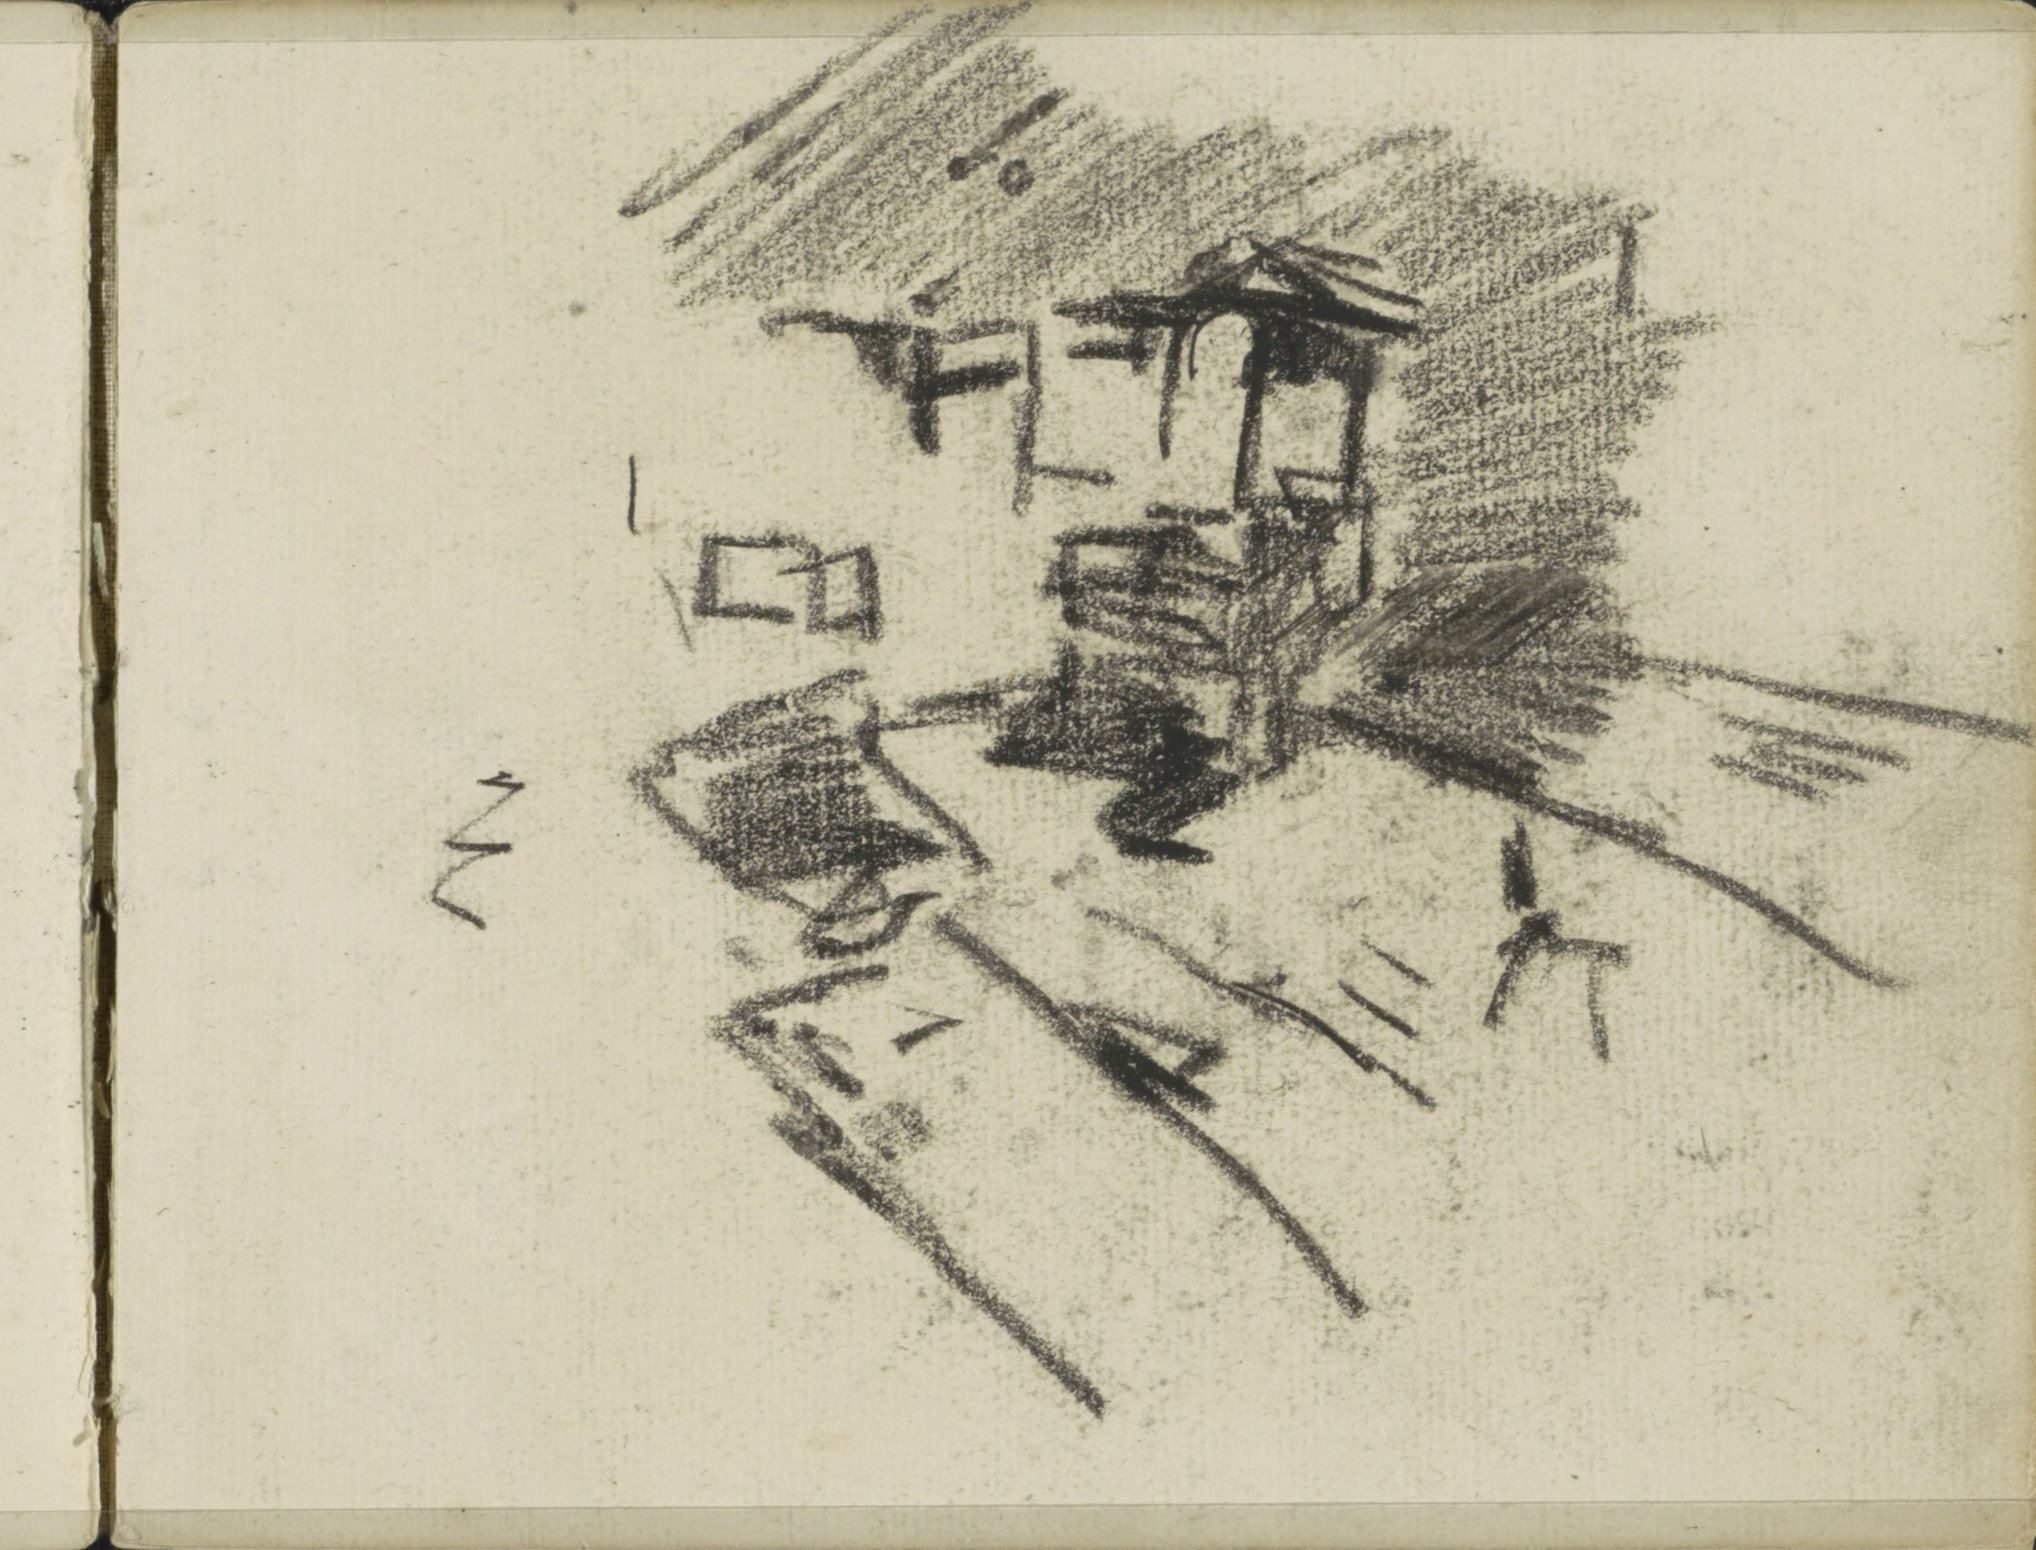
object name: sketchbook leaf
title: Gezicht in Amsterdam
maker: george hendrik breitner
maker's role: draughtsman, painter, print maker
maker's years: 1857-1923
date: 1886-1903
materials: chalk, paper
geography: amsterdam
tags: city-view, and landscape with man-made constructions, amsterdam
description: Pagina 40 uit een schetsboek met 27 bladen.